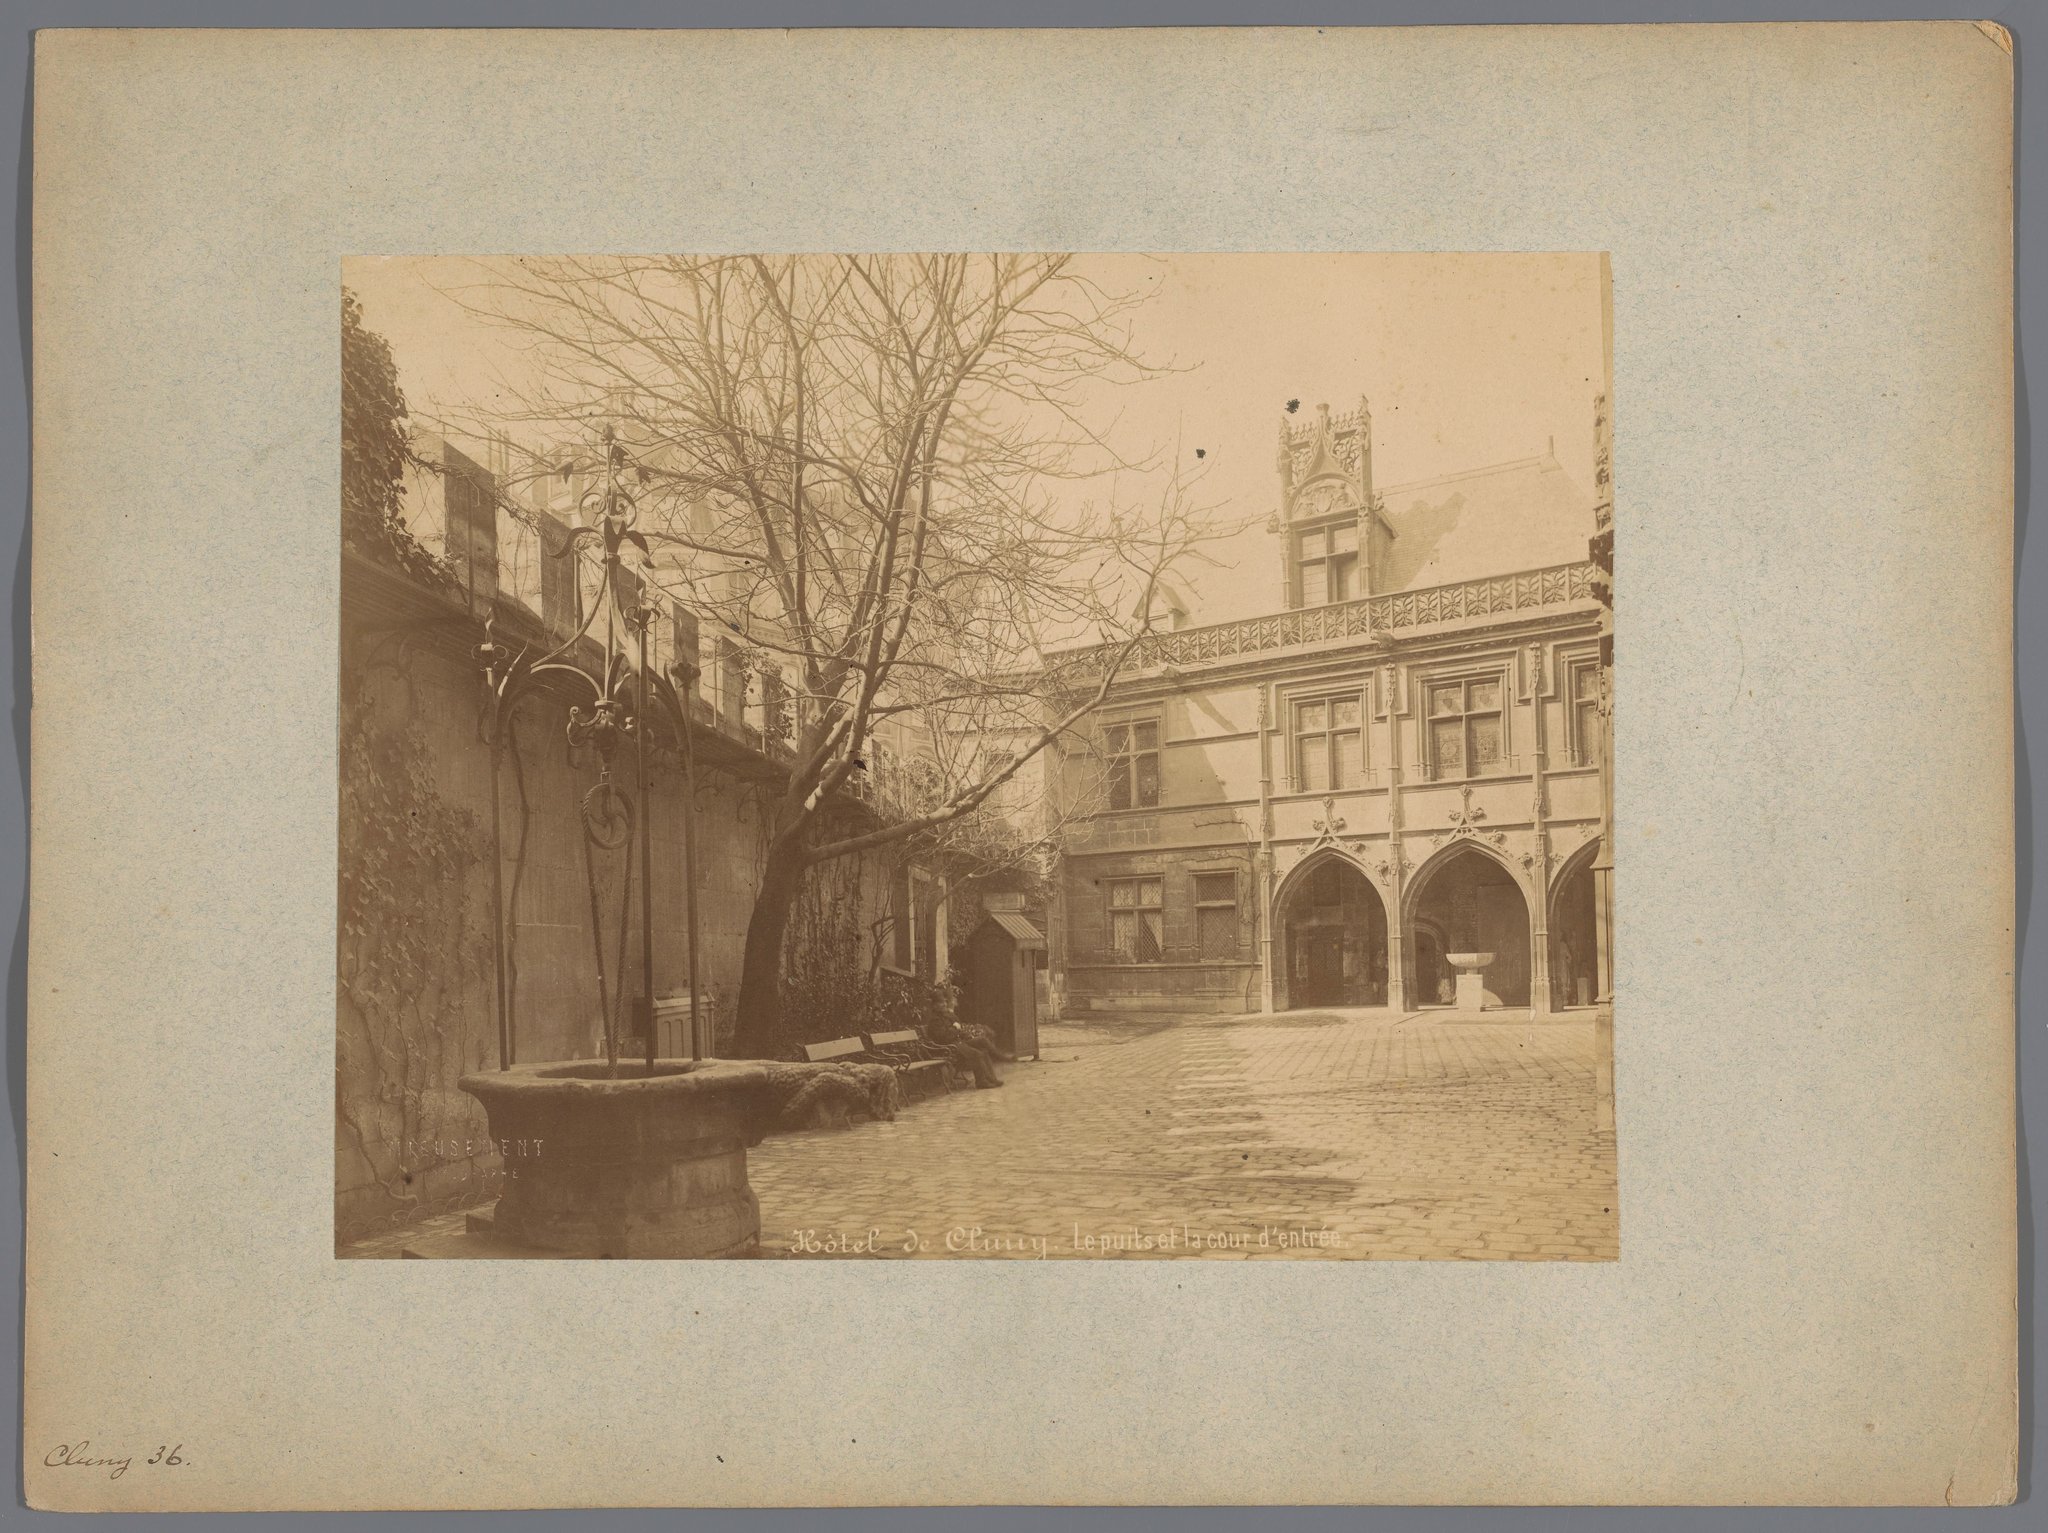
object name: photograph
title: Le puits et la cour d'entrée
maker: séraphin-médéric mieusement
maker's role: fotograaf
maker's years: 1840-1905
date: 1850-1900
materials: cardboard, photographic support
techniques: albumen print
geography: paris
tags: courtyard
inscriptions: workshop stamp: ‘Mieusement/ Photographe’, number: ‘Cluny 36’, collector's mark: ‘Rijks-normaalschool voor teekenonderwijzers Amsterdam’ Lugt 3937